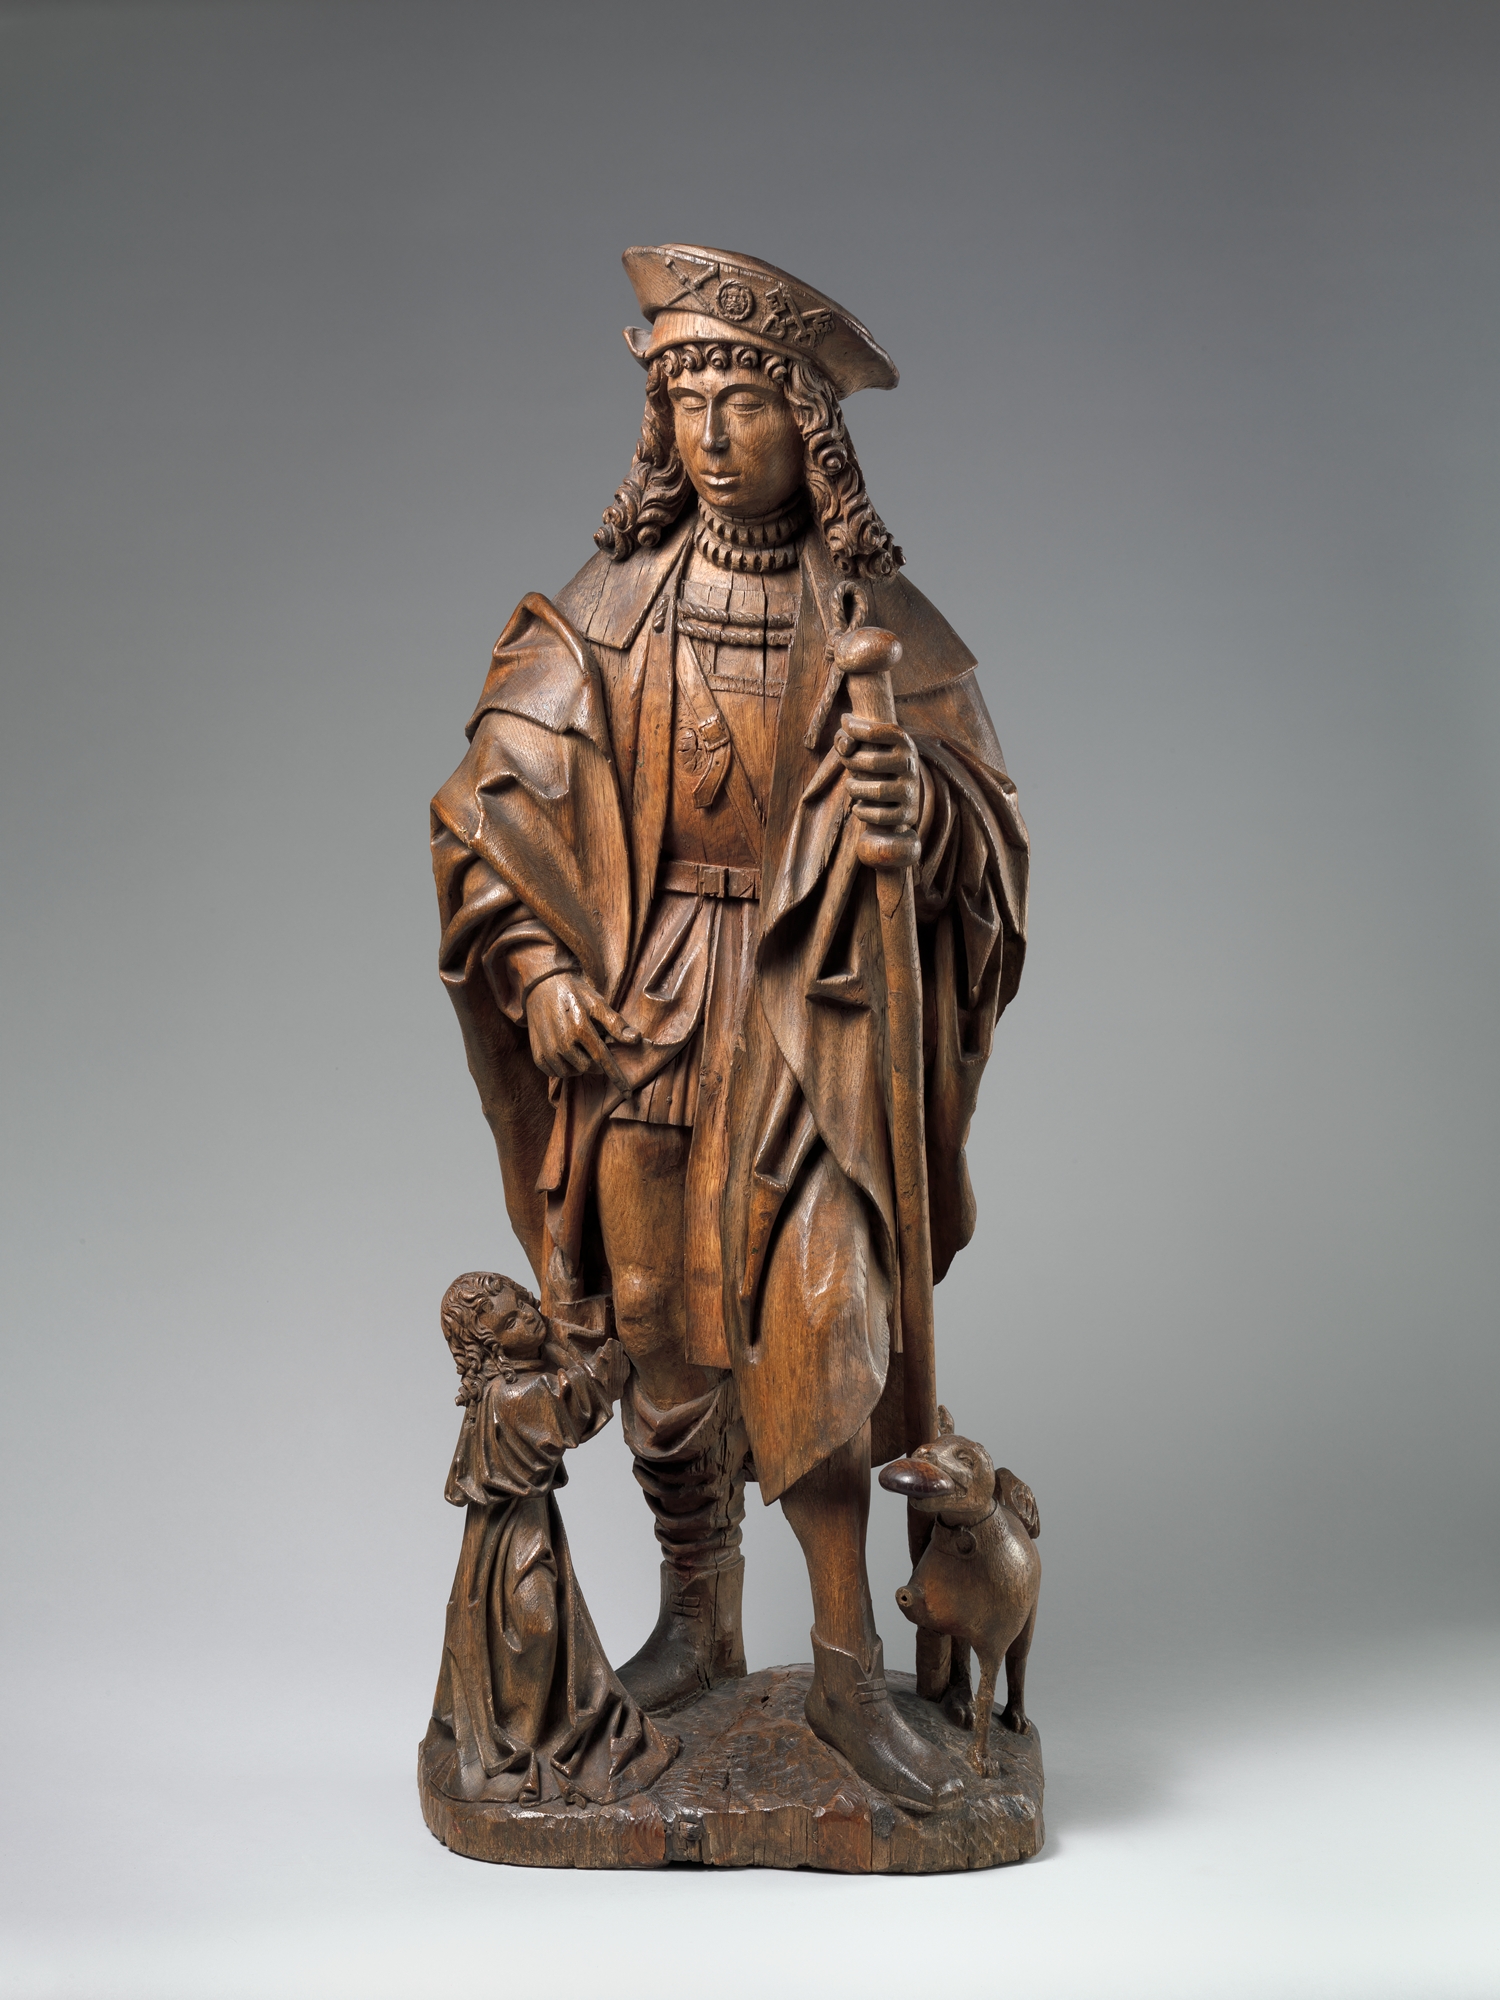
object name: statue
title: Saint Roch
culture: german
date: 1501-1533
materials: wood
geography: germany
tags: animals,children,men